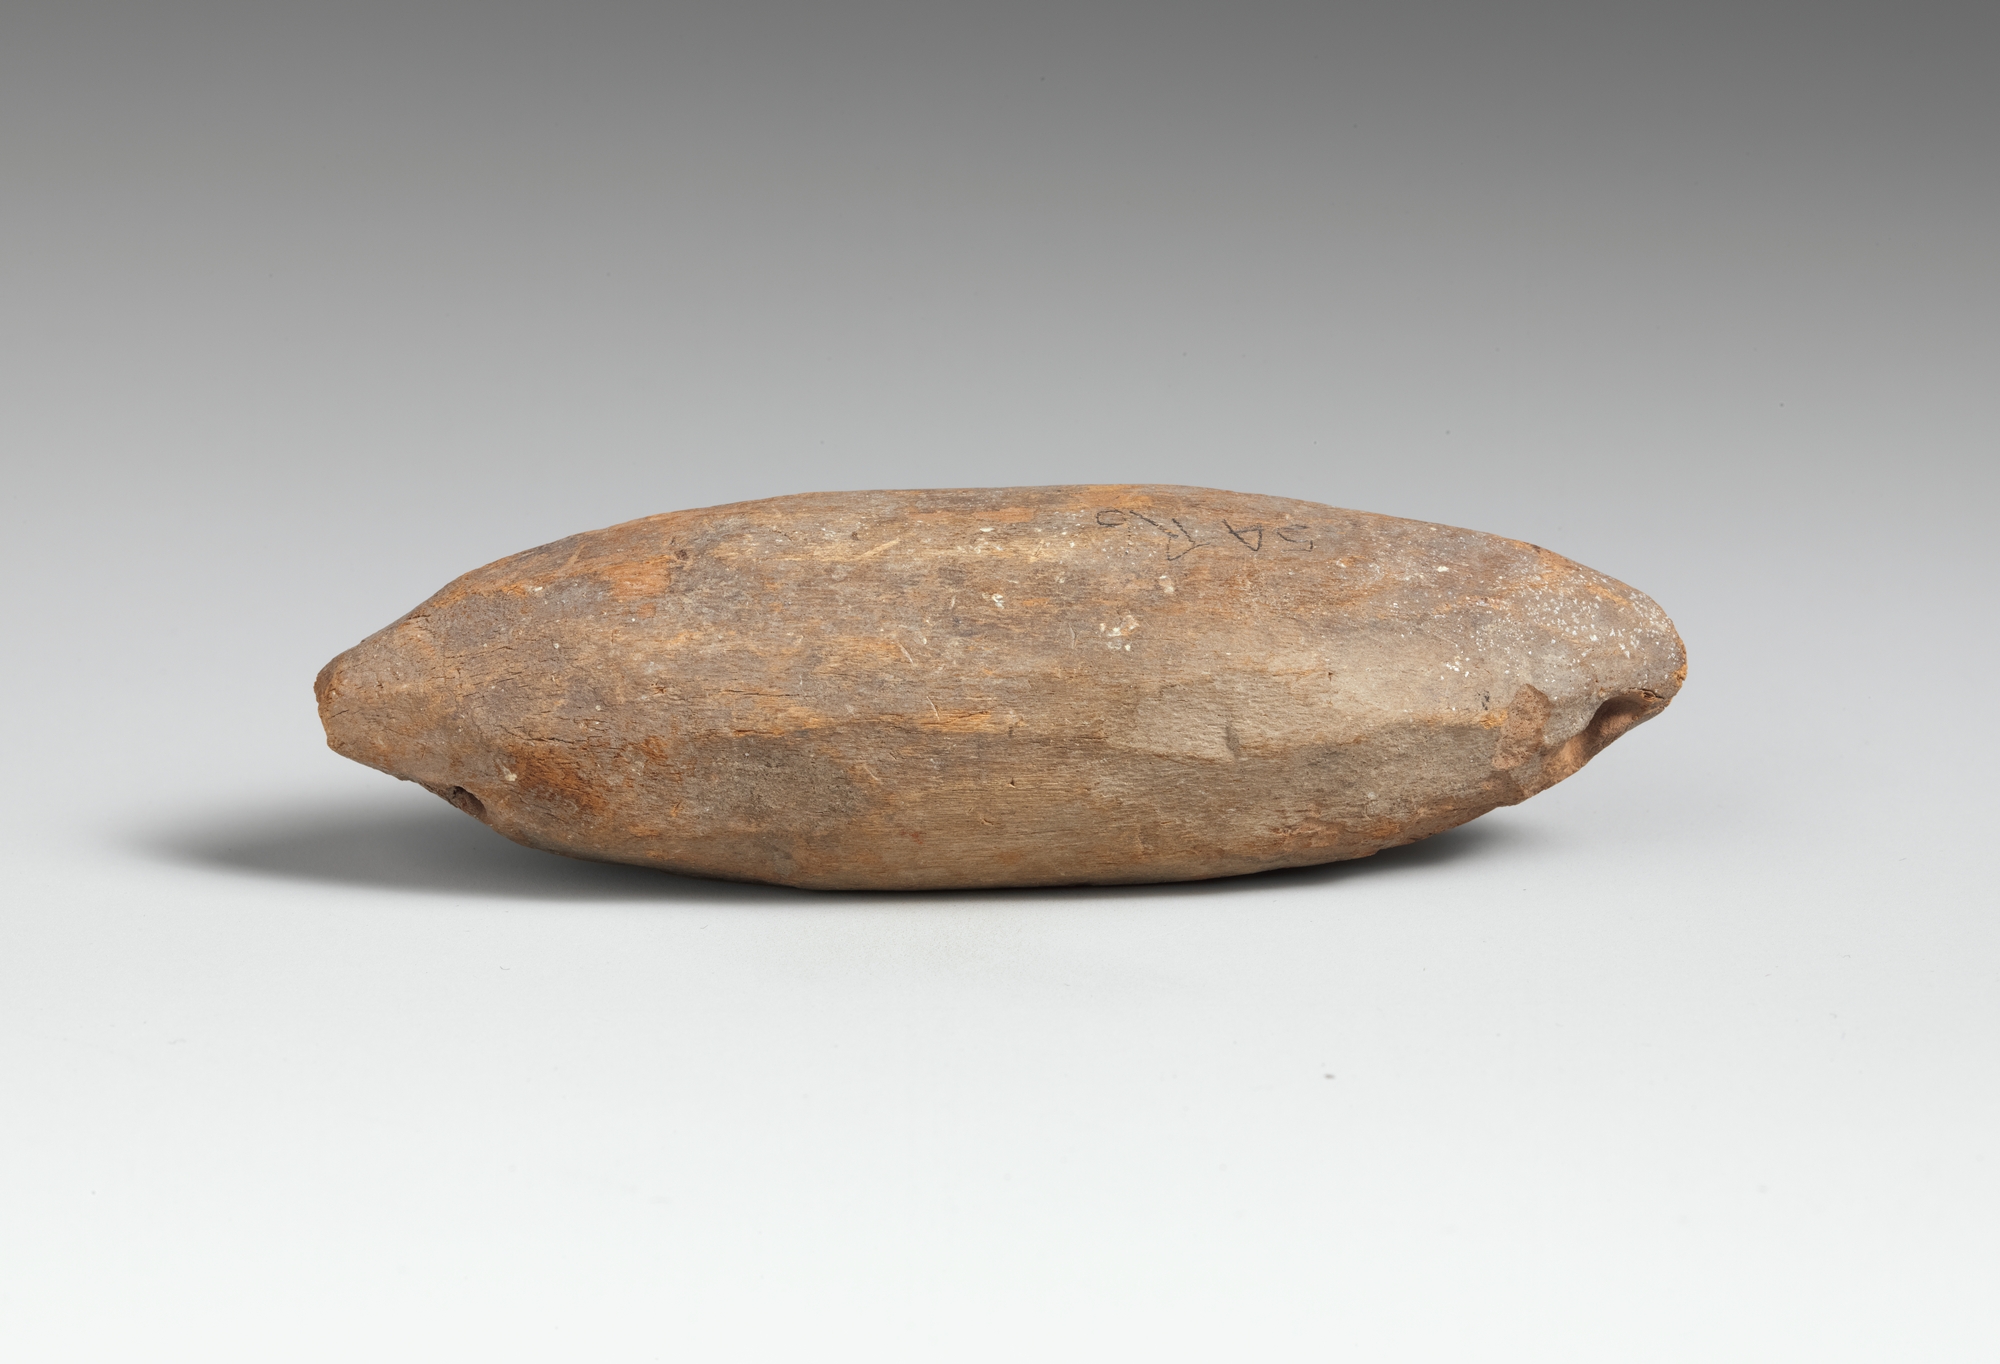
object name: game piece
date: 2030-1640 BCE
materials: wood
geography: egypt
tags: games